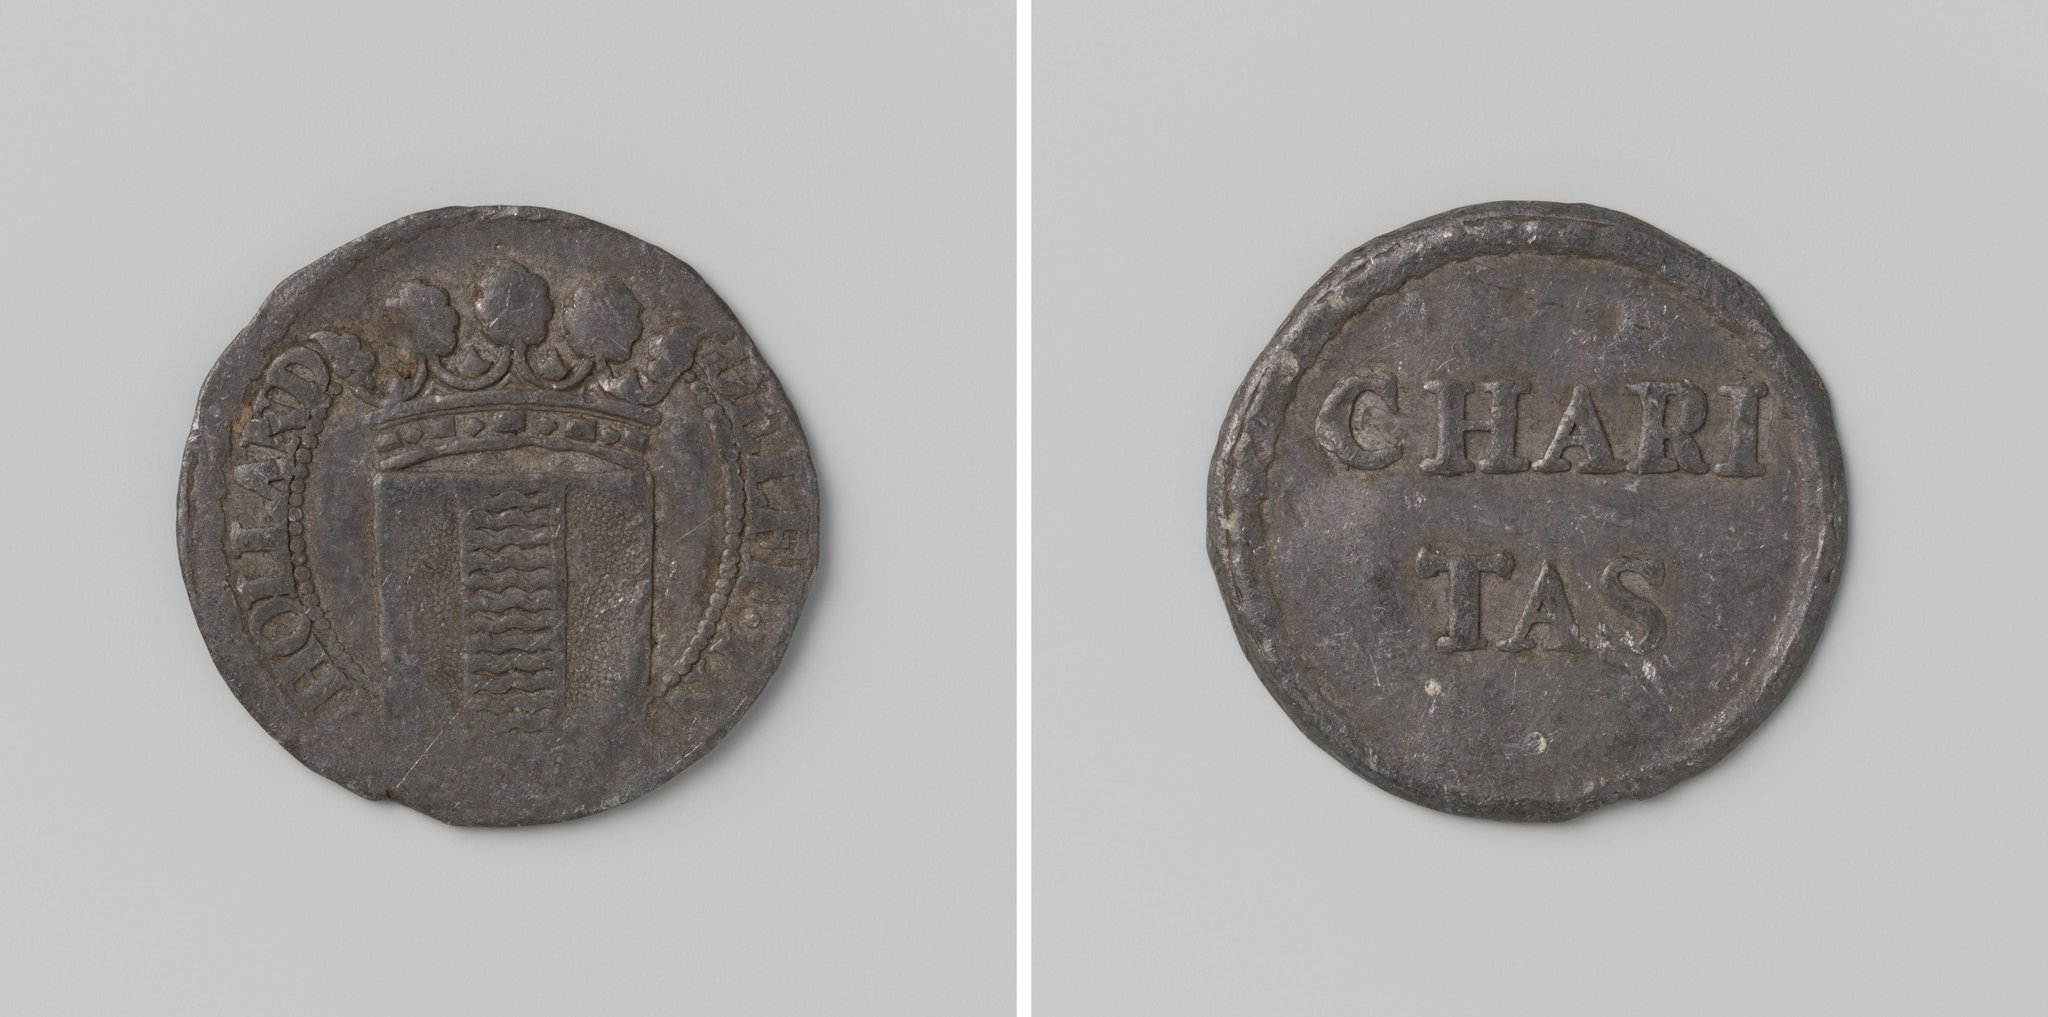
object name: armenloodje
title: Charitatenhuis te Delft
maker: Anonymous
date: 1600-1800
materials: lead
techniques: casting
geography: delft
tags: delft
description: Loden penning. Voorzijde: gekroond wapenschild binnen omschrift. Keerzijde: opschrift